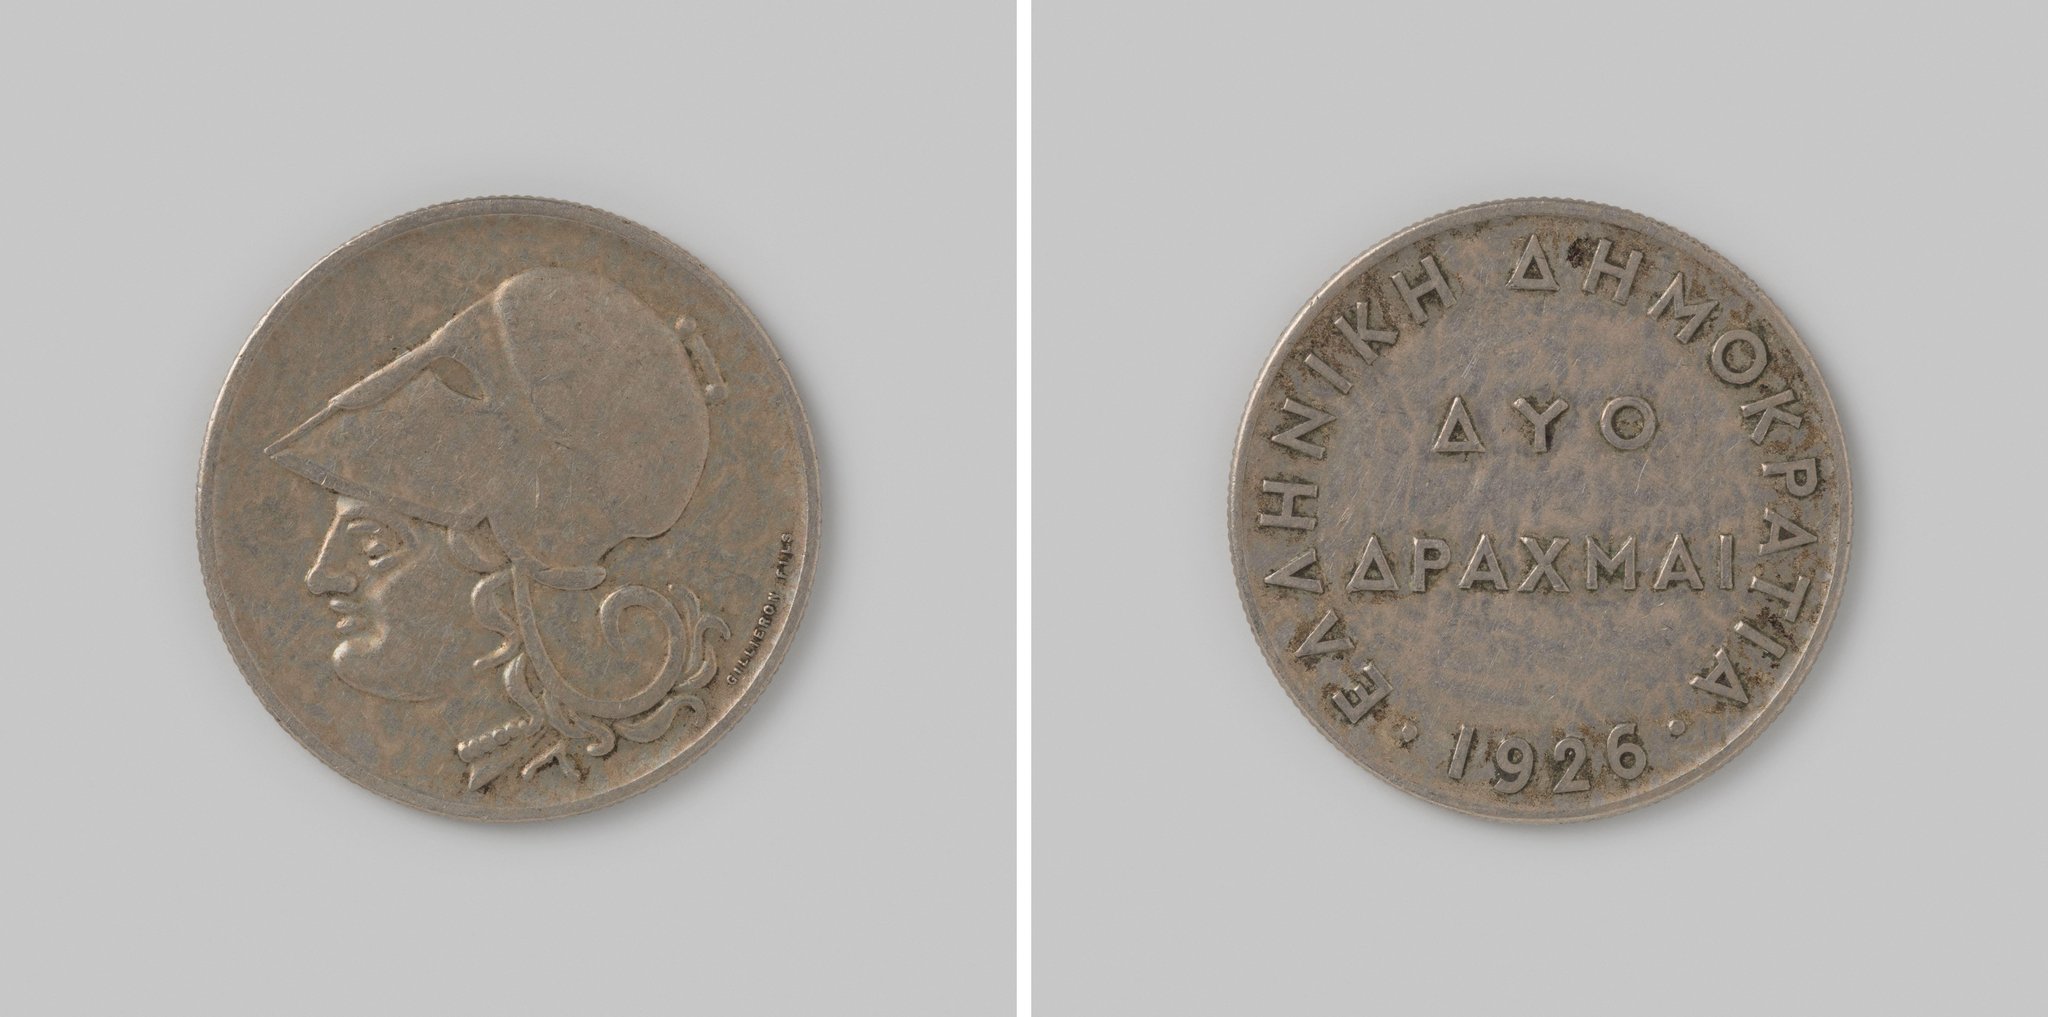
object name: coin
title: 2 drachmen uit Griekenland, 1926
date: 1926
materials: nickel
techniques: striking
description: Koper-nikkelen munt. Voorzijde: gehelmde Athene naar links. Keerzijde: waarde-aanduiding in twee regels. Jaartal onderaan. Kartelrand.